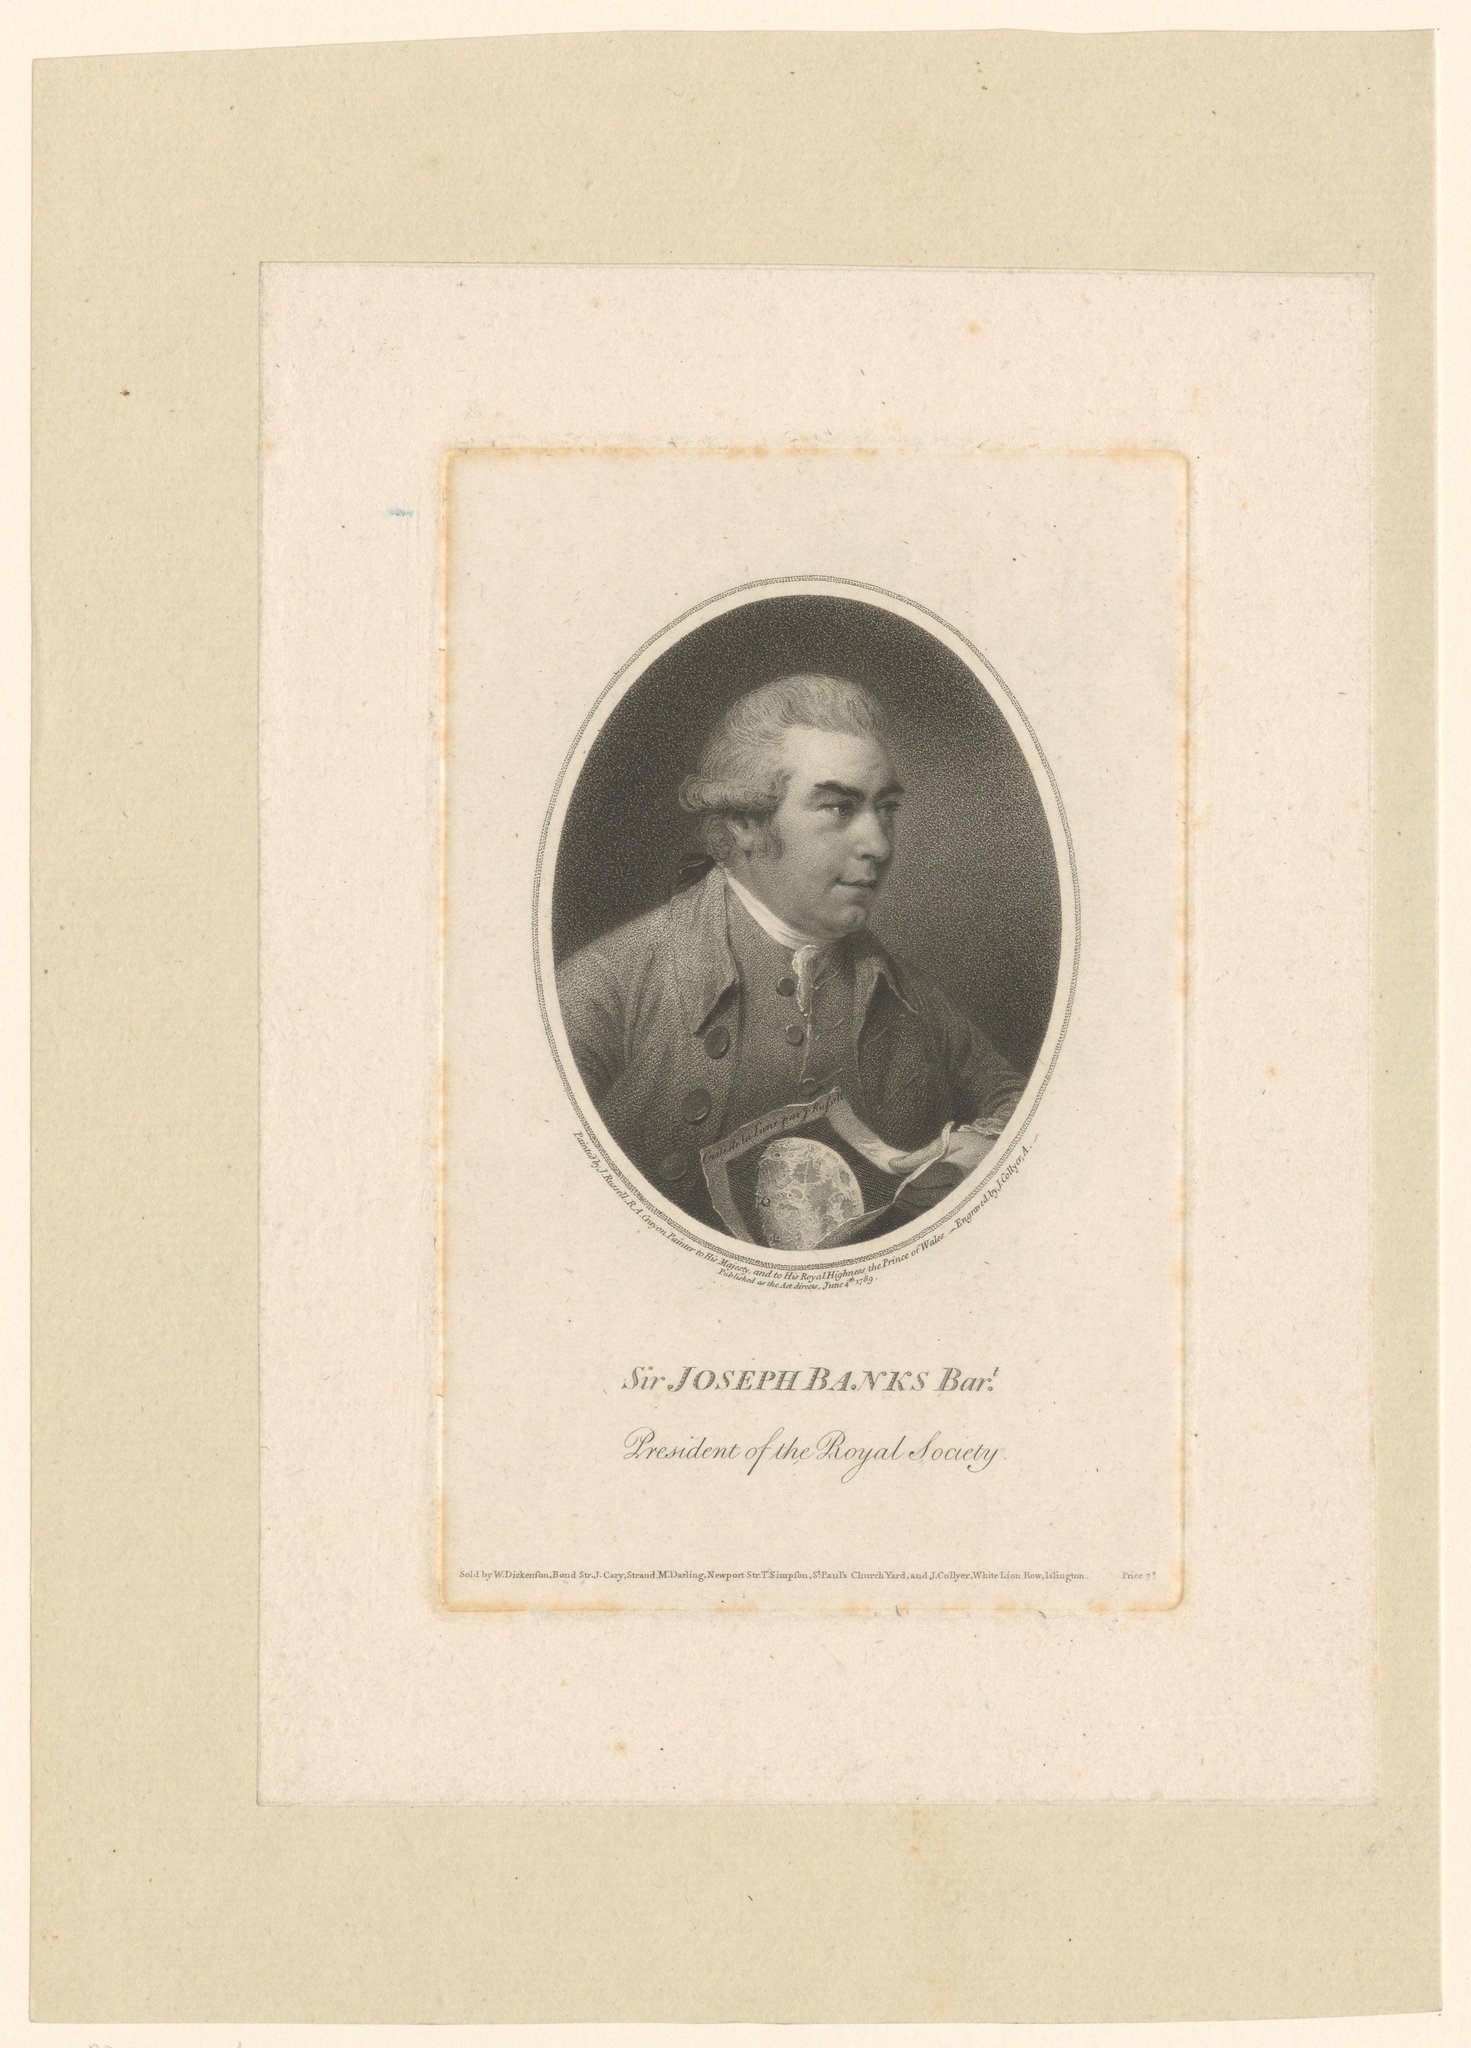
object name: print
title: Portret van Joseph Banks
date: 1790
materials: paper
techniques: stippling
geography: london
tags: london, joseph banks, botany (+ portrait of scholar, scientist), historical persons, scholar, philosopher (+ portrait of scholar, scientist)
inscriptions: collector's mark: Lugt 2228